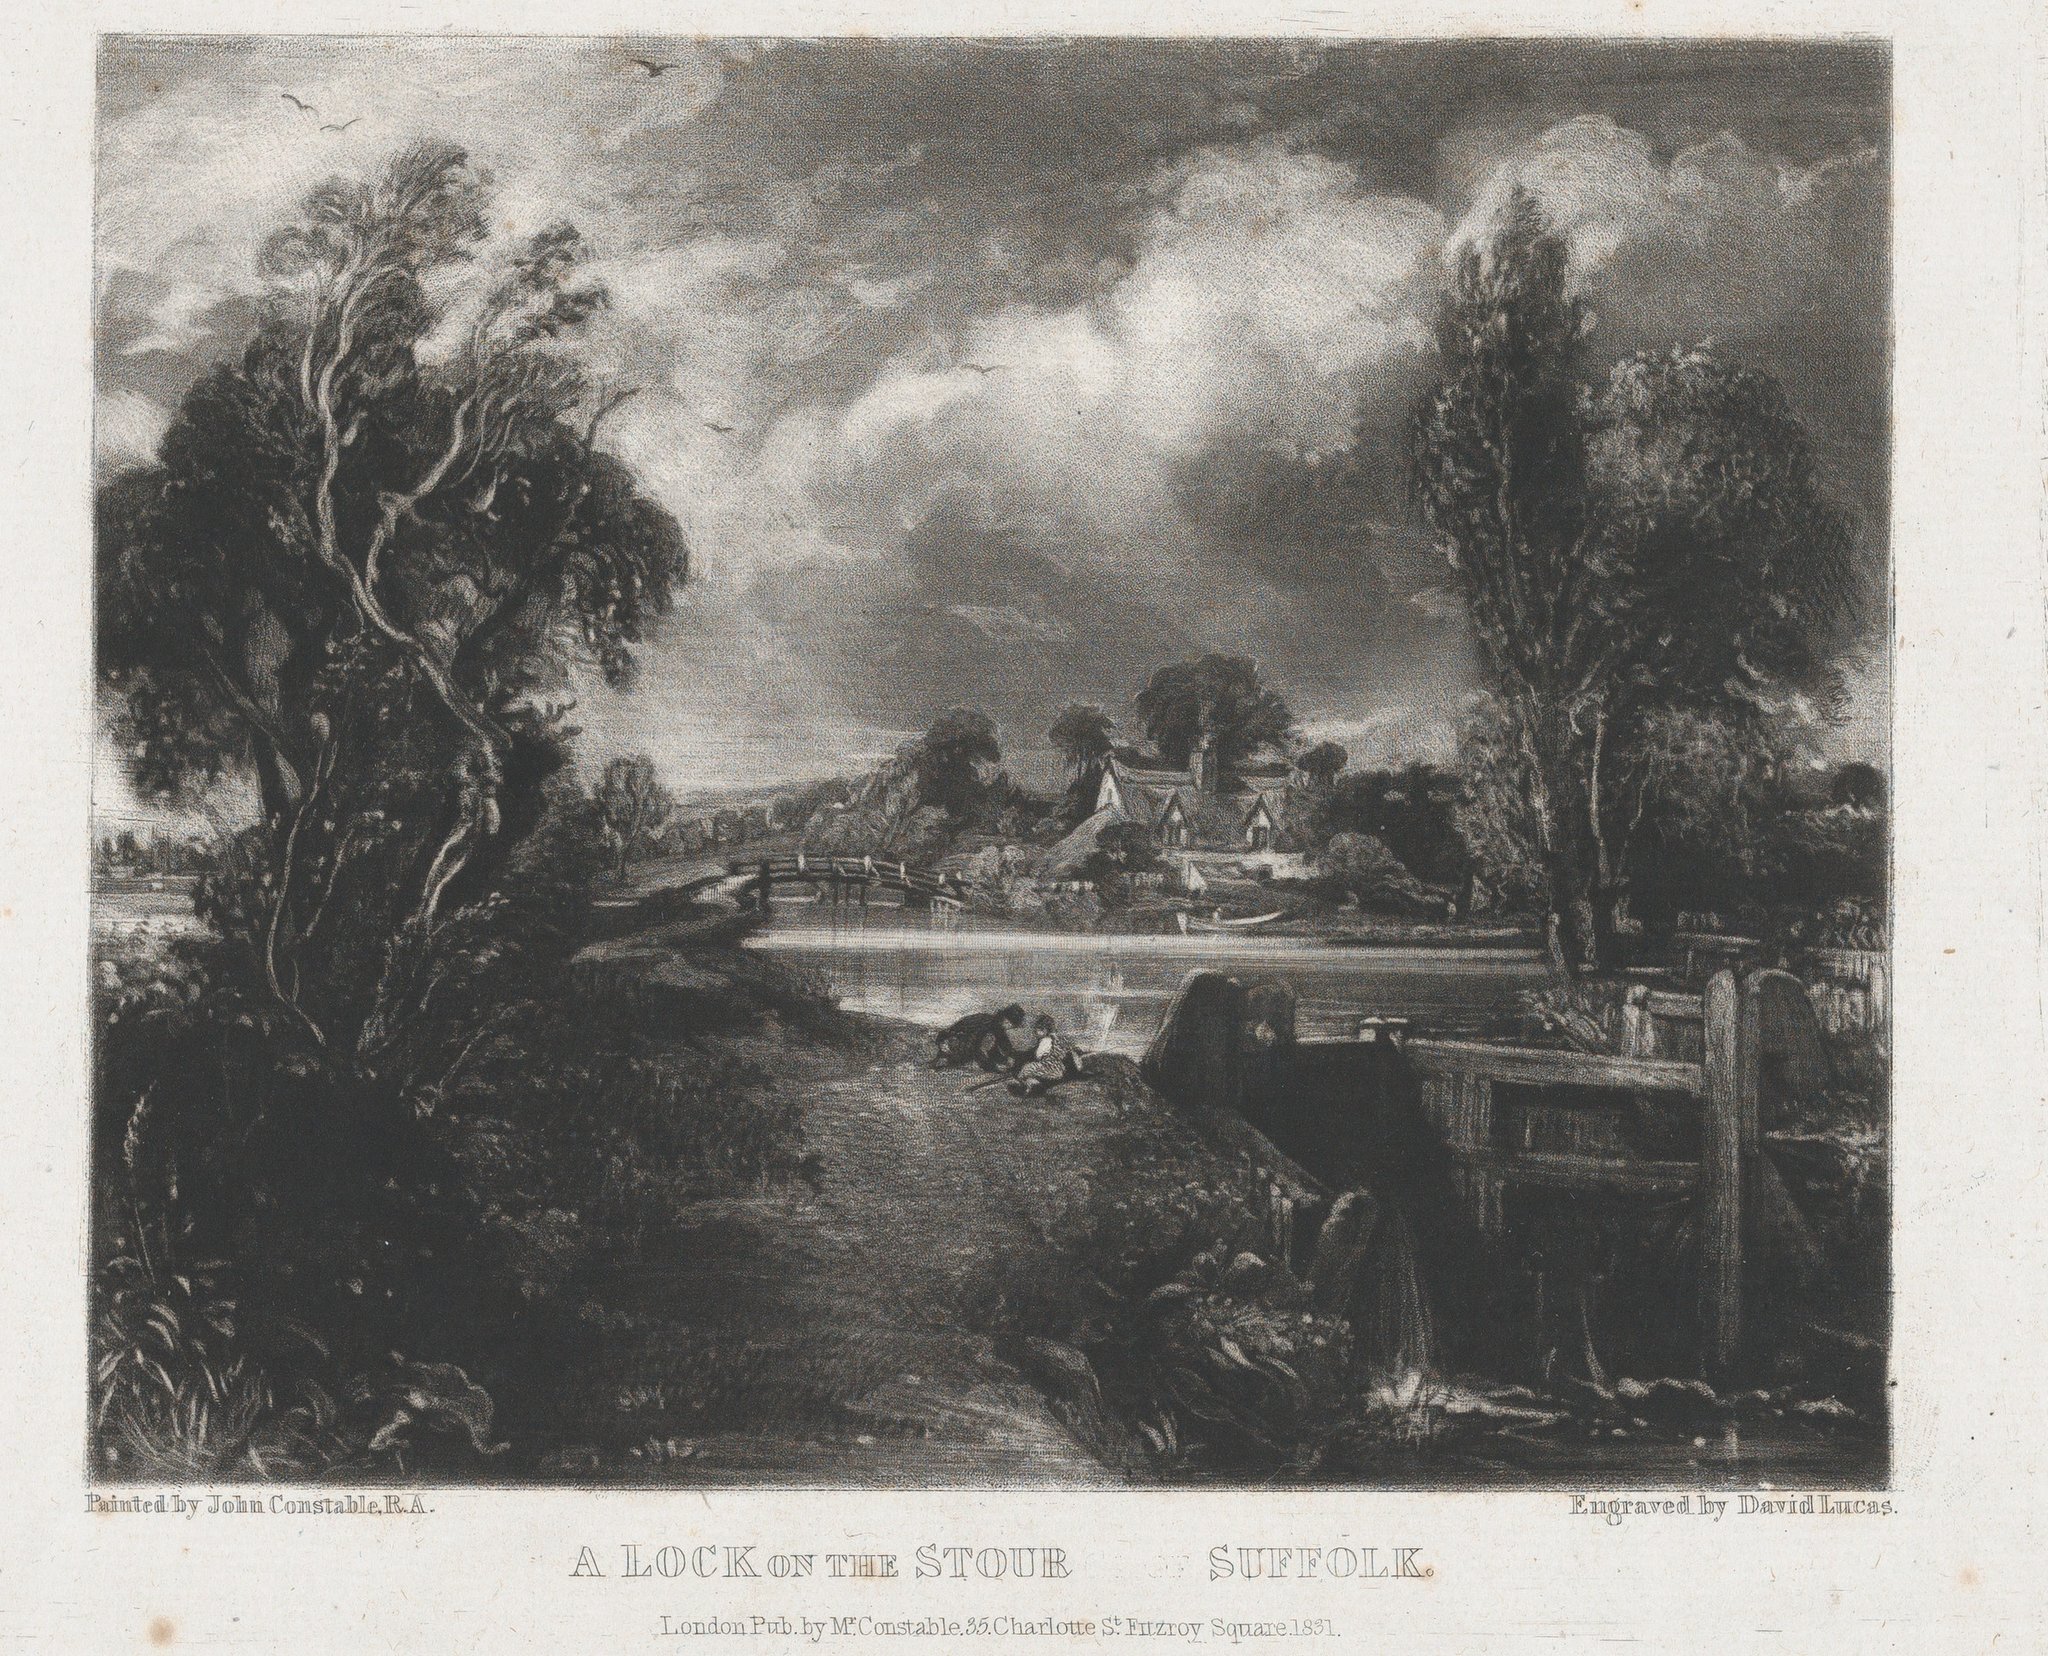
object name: print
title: A Lock on the Stour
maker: david lucas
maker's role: artist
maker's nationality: british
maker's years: 1802-1881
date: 1831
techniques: mezzotint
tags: landscapes,trees